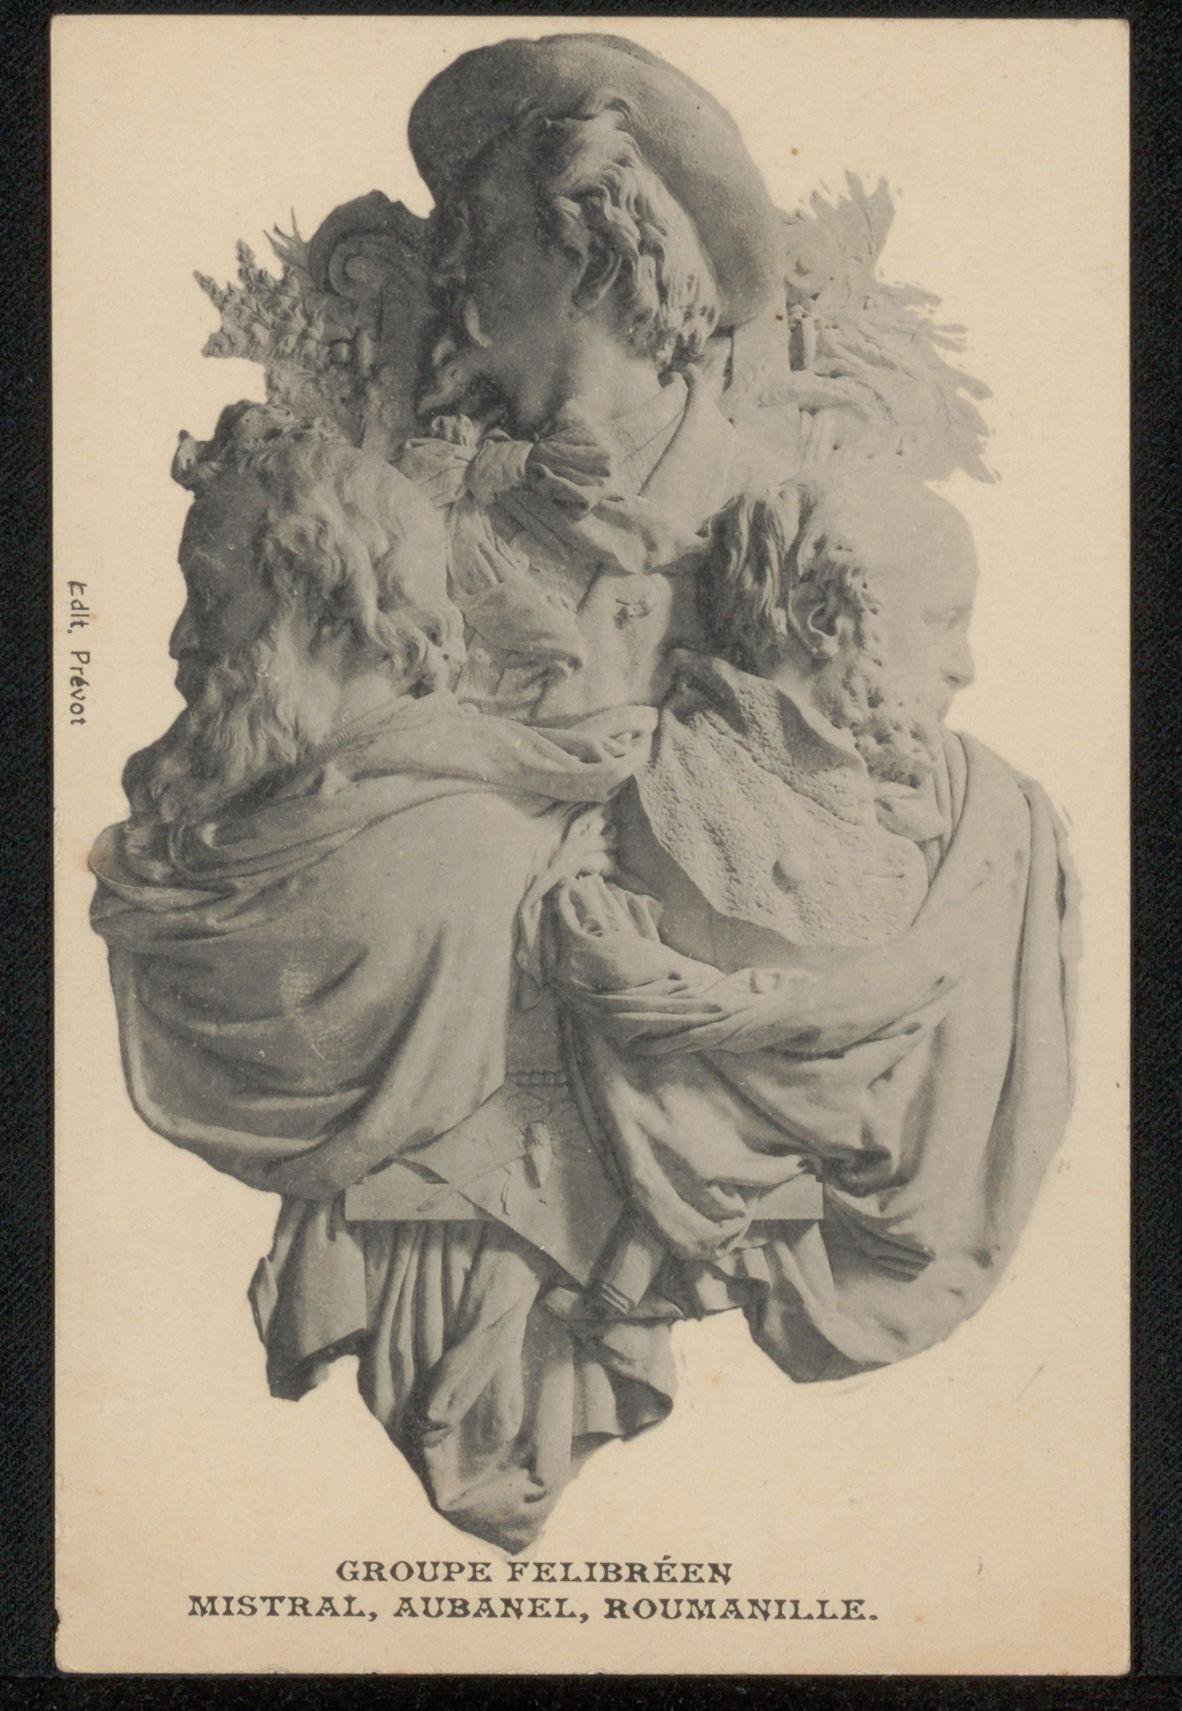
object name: ansichtkaart, prentbriefkaart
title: Prentbriefkaart aan Philip Zilcken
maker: prévot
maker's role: publisher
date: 1867-1930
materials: cardboard, ink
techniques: photograph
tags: frédéric mistral, the hague, painter, draughtsman, philip zilcken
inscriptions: collector's mark: ‘RPK’